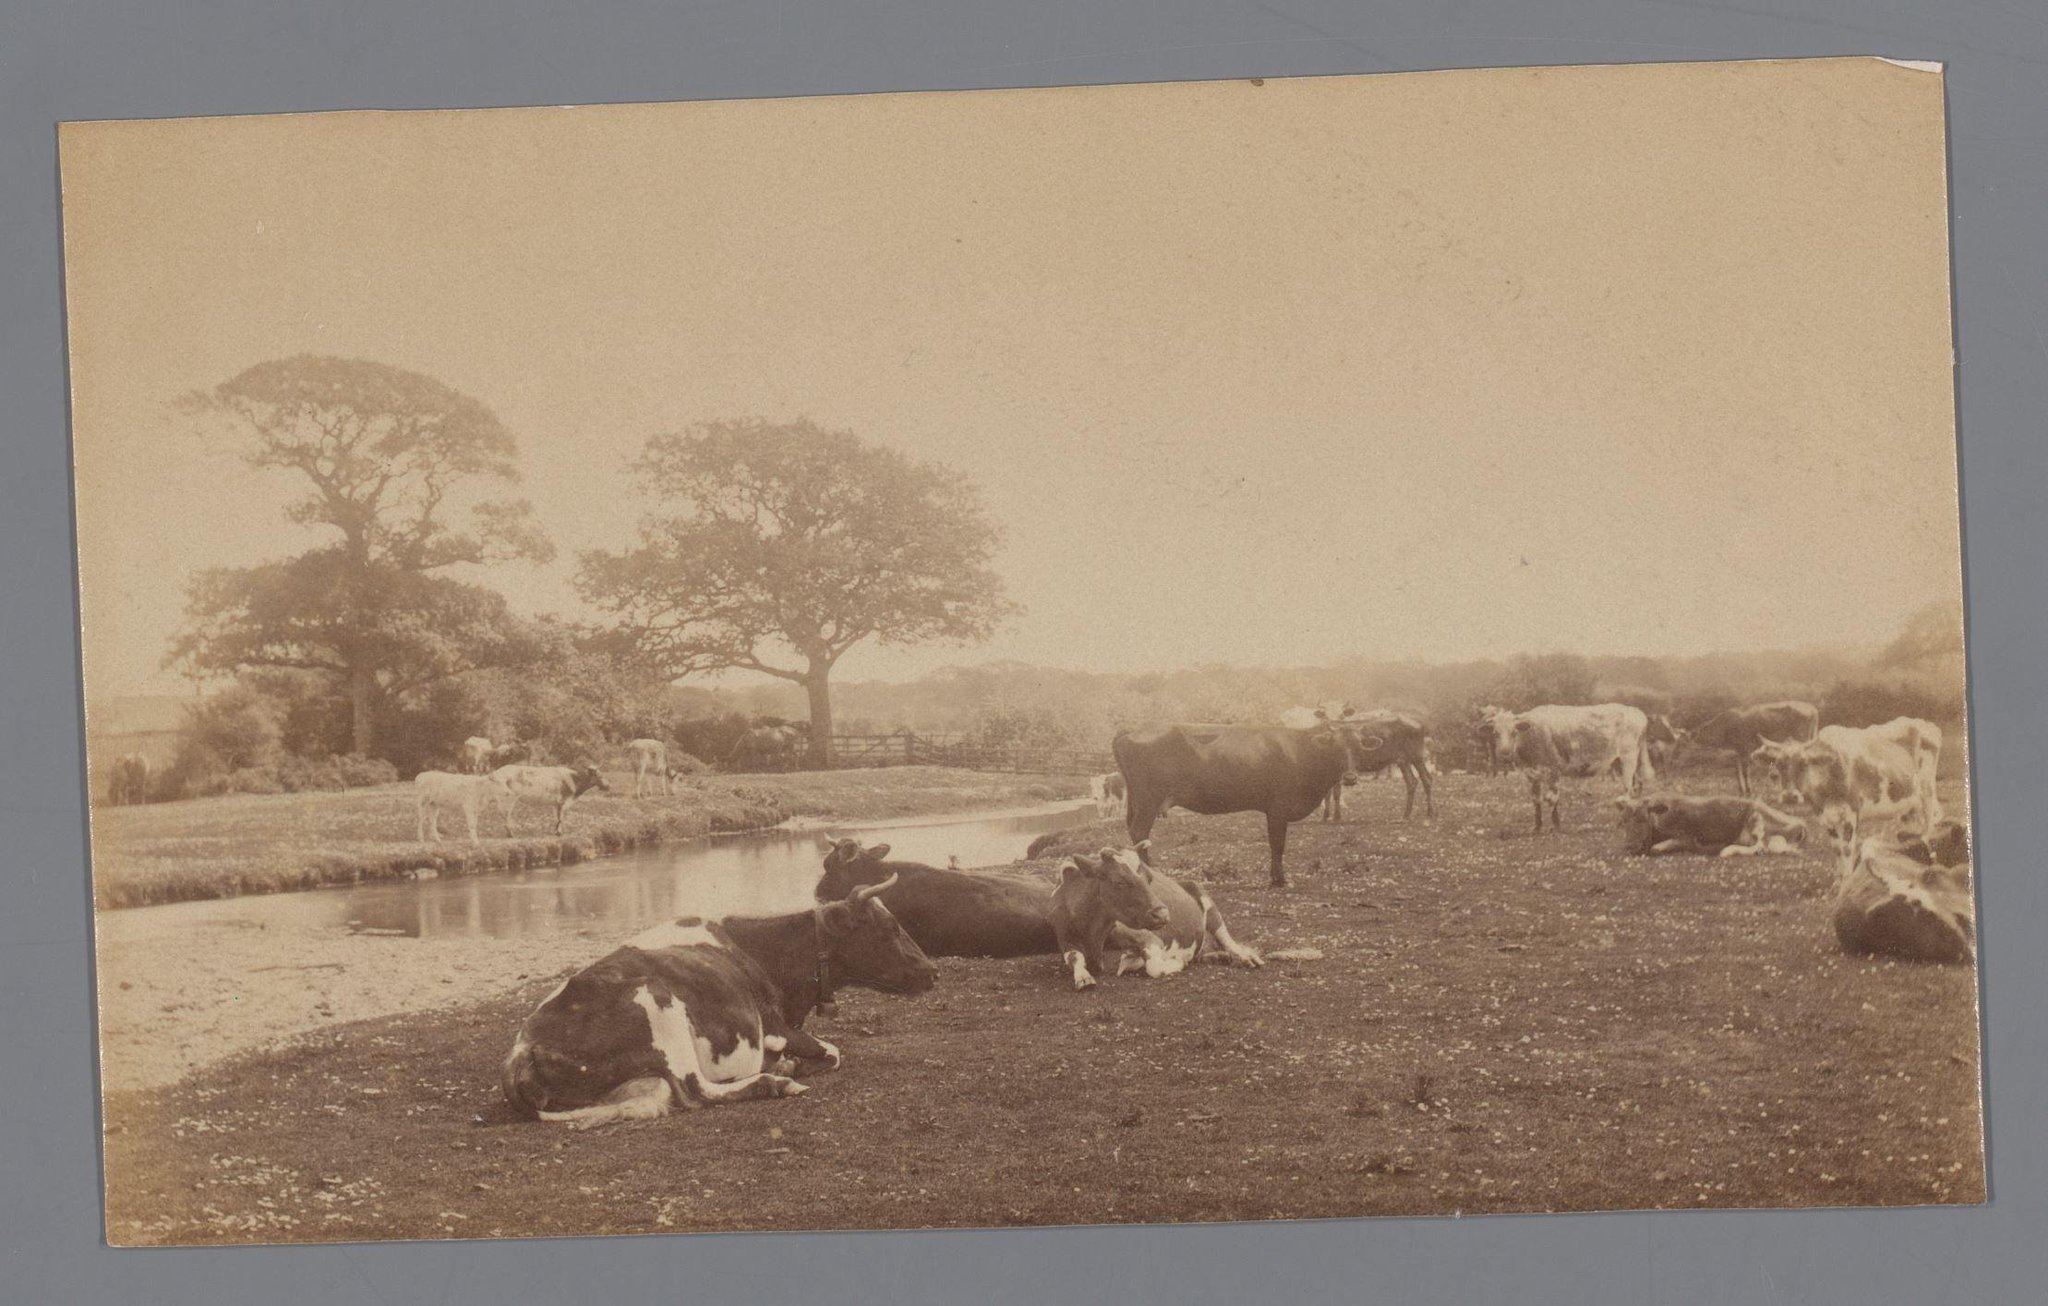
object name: photograph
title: Landschap met koeien langs waterkant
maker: Anonymous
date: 1875-1890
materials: paper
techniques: albumen print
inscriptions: inscription: ‘q q’, inscription: ‘Cattle Study//Brokenhand (?) River’